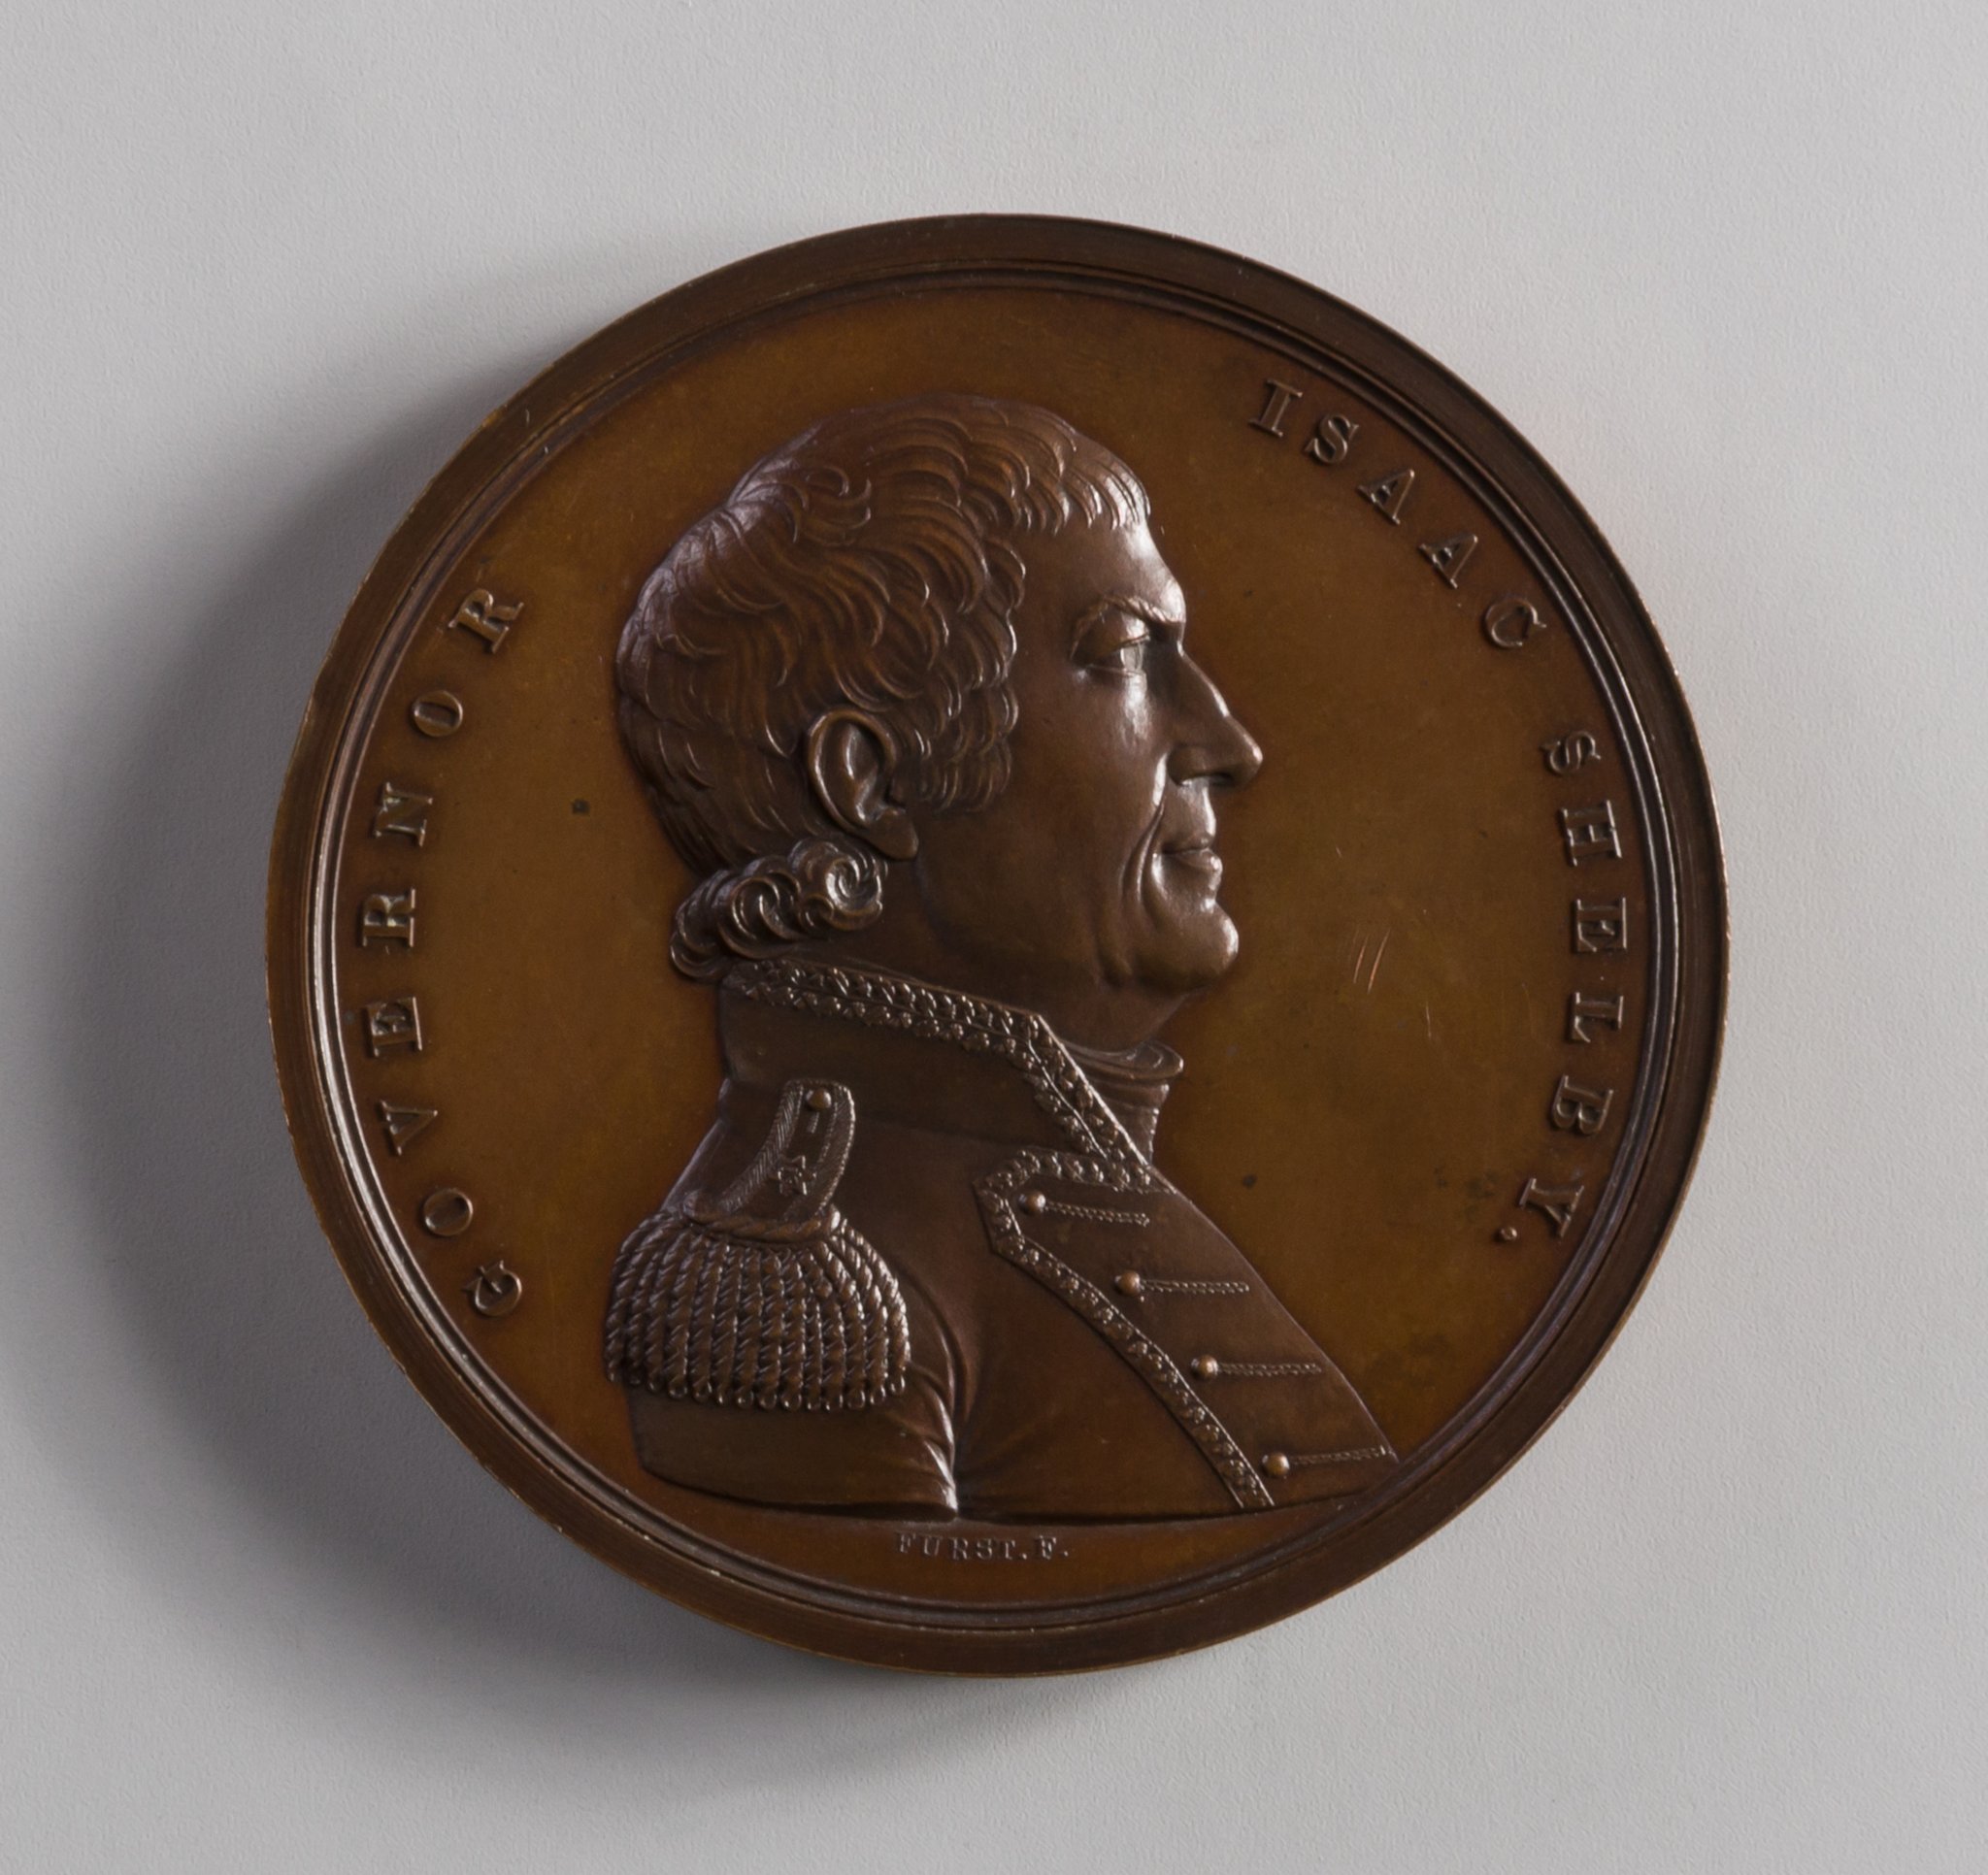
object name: medal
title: Medal of Governor I. Shelby of Kentucky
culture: american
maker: moritz fürst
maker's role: maker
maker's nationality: hungarian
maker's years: 1782-1882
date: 1800-1830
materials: bronze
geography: united states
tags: men,profiles